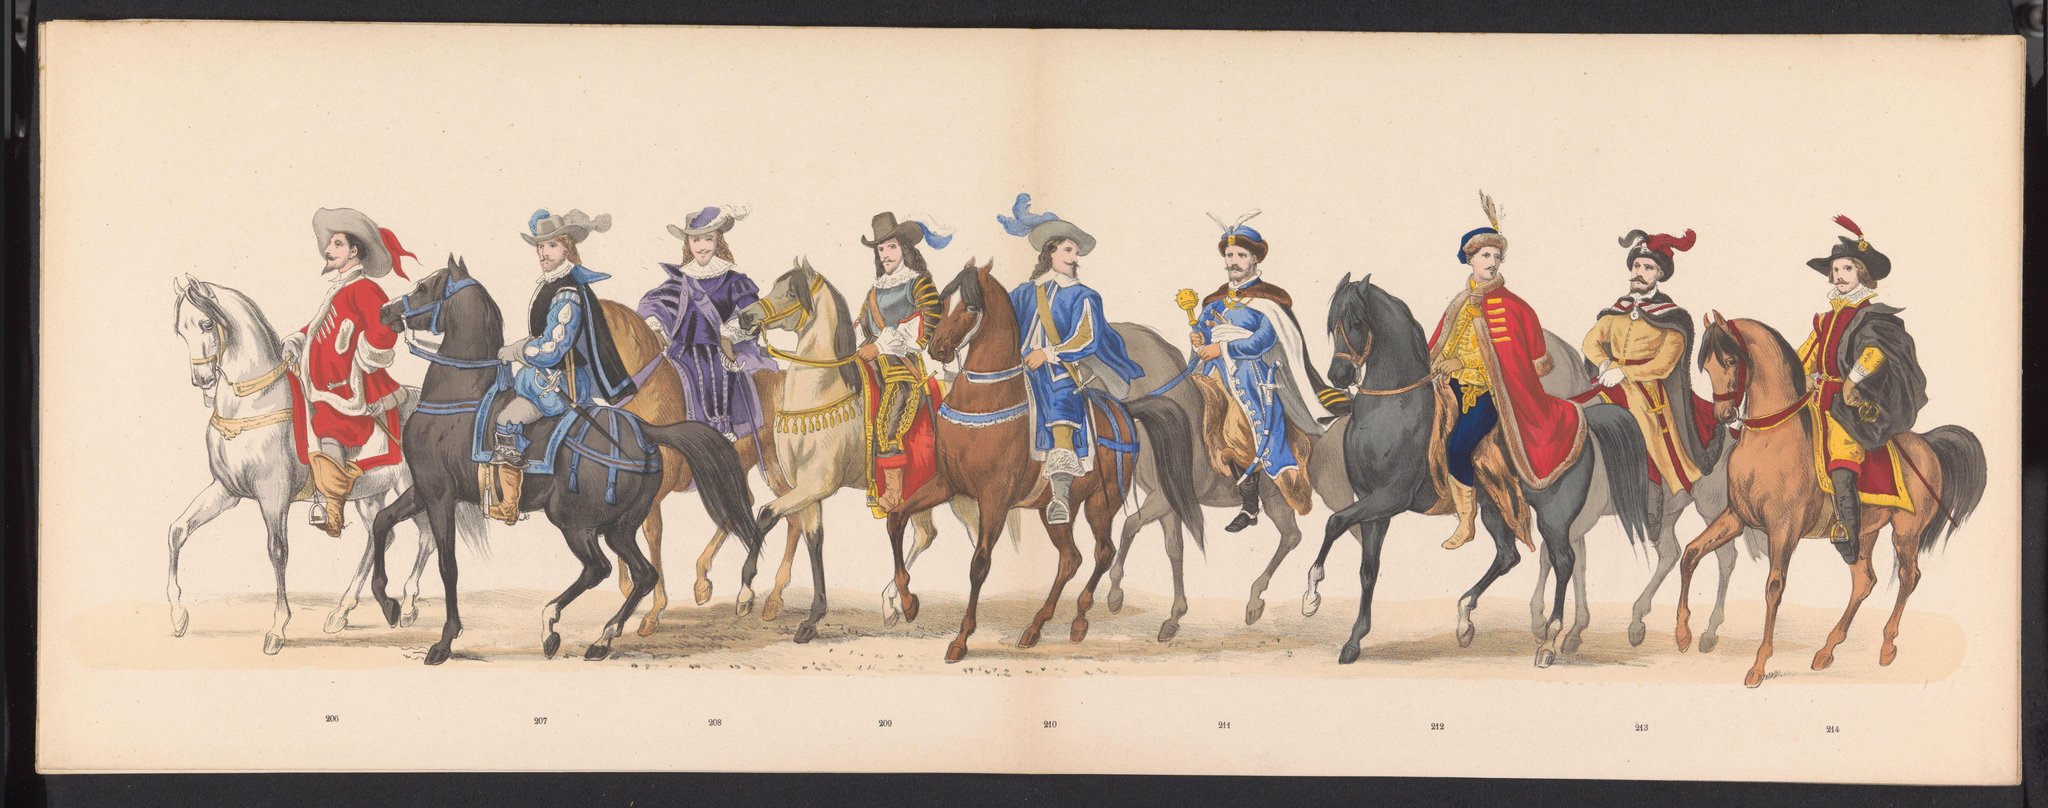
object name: print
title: Maskerade gehouden door de leden van het Leidsche studentencorps den 15den Juni 1875 ter viering van den 300sten verjaardag der Leidsche Hoogeschool, voorstellende de Leidsche Hoogeschool, afgebeeld in de beroemdste en merkwaardigste mannen, die van hare stichting af hun naam aan den haren hebben verbonden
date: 1875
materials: paper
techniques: hand coloring, lithograph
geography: leiden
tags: students' pageant, costumes used in pageants, leiden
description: Historische gekostumeerde optocht van de studenten van de Leidse Hogeschool gehouden op 15 juni 1875 ter gelegenheid van het 300-jarig bestaan van de Hogeschool. De optocht verbeeldt de beroemdste mannen verbonden aan de Hogeschool. Veertiende plaat met de groepen genummerd 206-214. Onderdeel van de serie van 21 aaneen geplakte bladen.